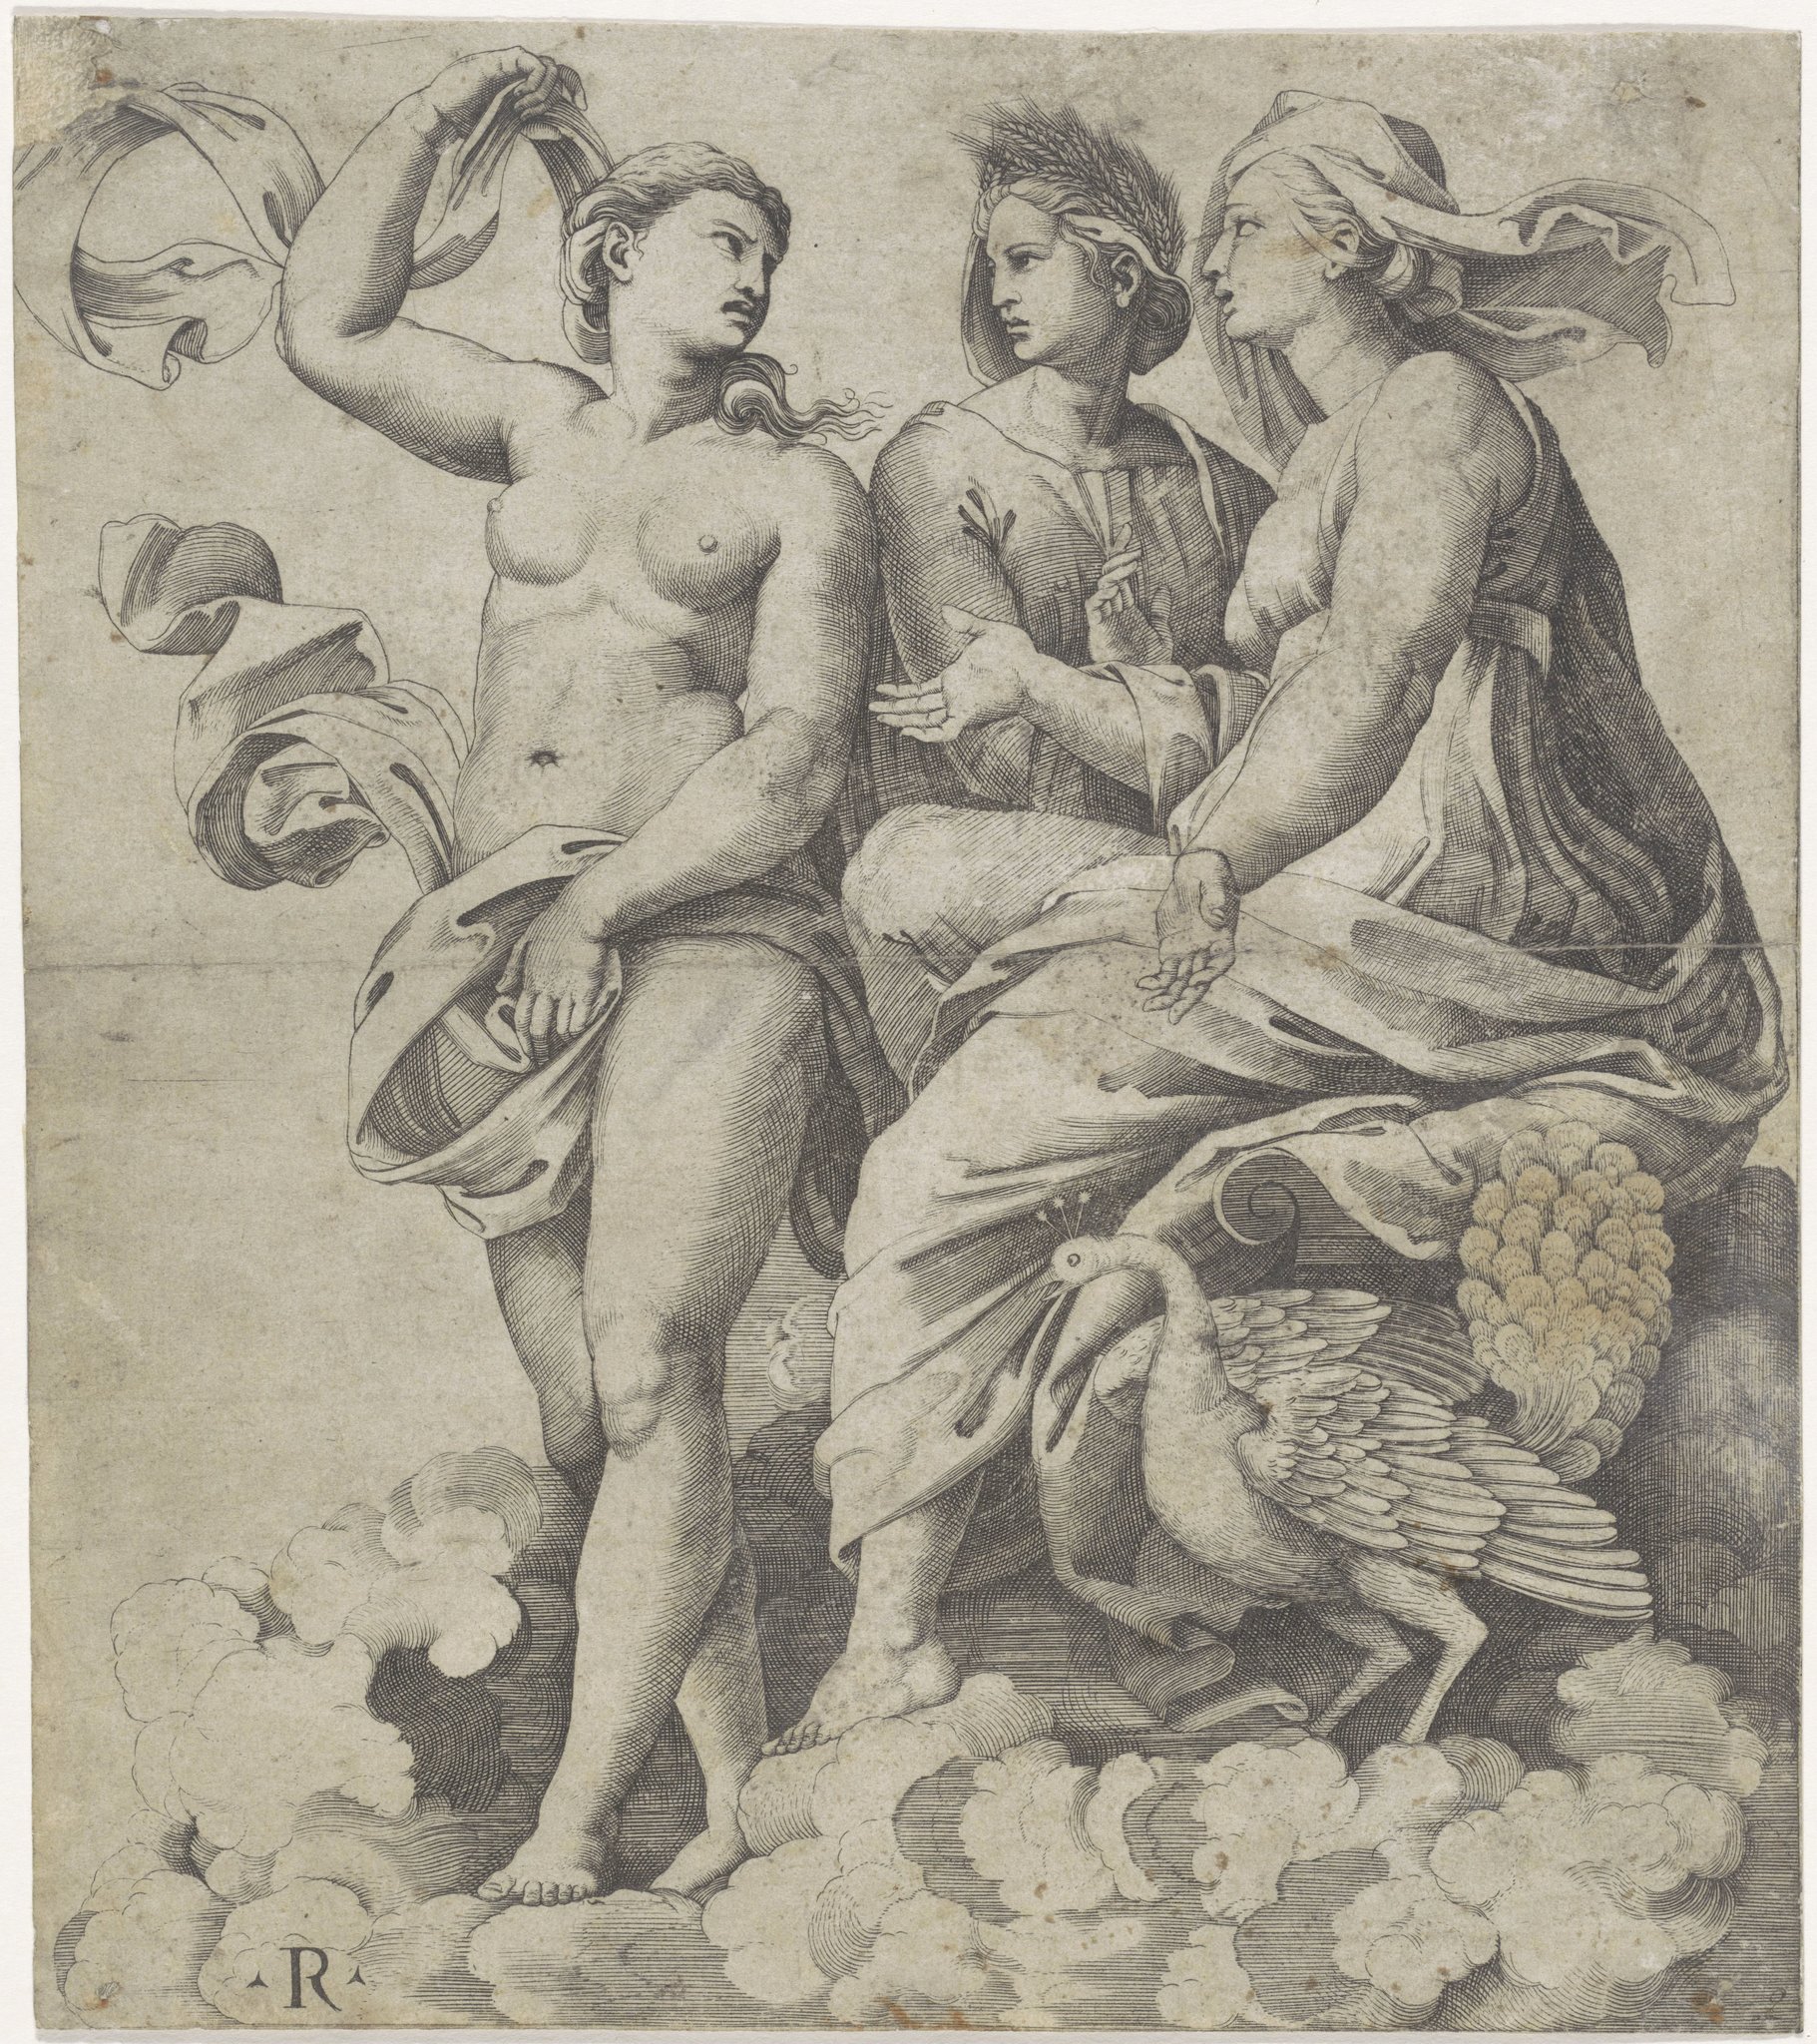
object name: print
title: Juno, Ceres en Psyche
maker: marco dente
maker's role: print maker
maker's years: 1486-1527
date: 1510-1527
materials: paper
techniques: engraving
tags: (story of) ceres (demeter), psyche with juno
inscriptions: collector's mark: Lugt 11, collector's mark: Lugt 10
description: Op een wolk van links naar rechts staan Psyche, Ceres en Juno. Naast Juno staat haar pauw.